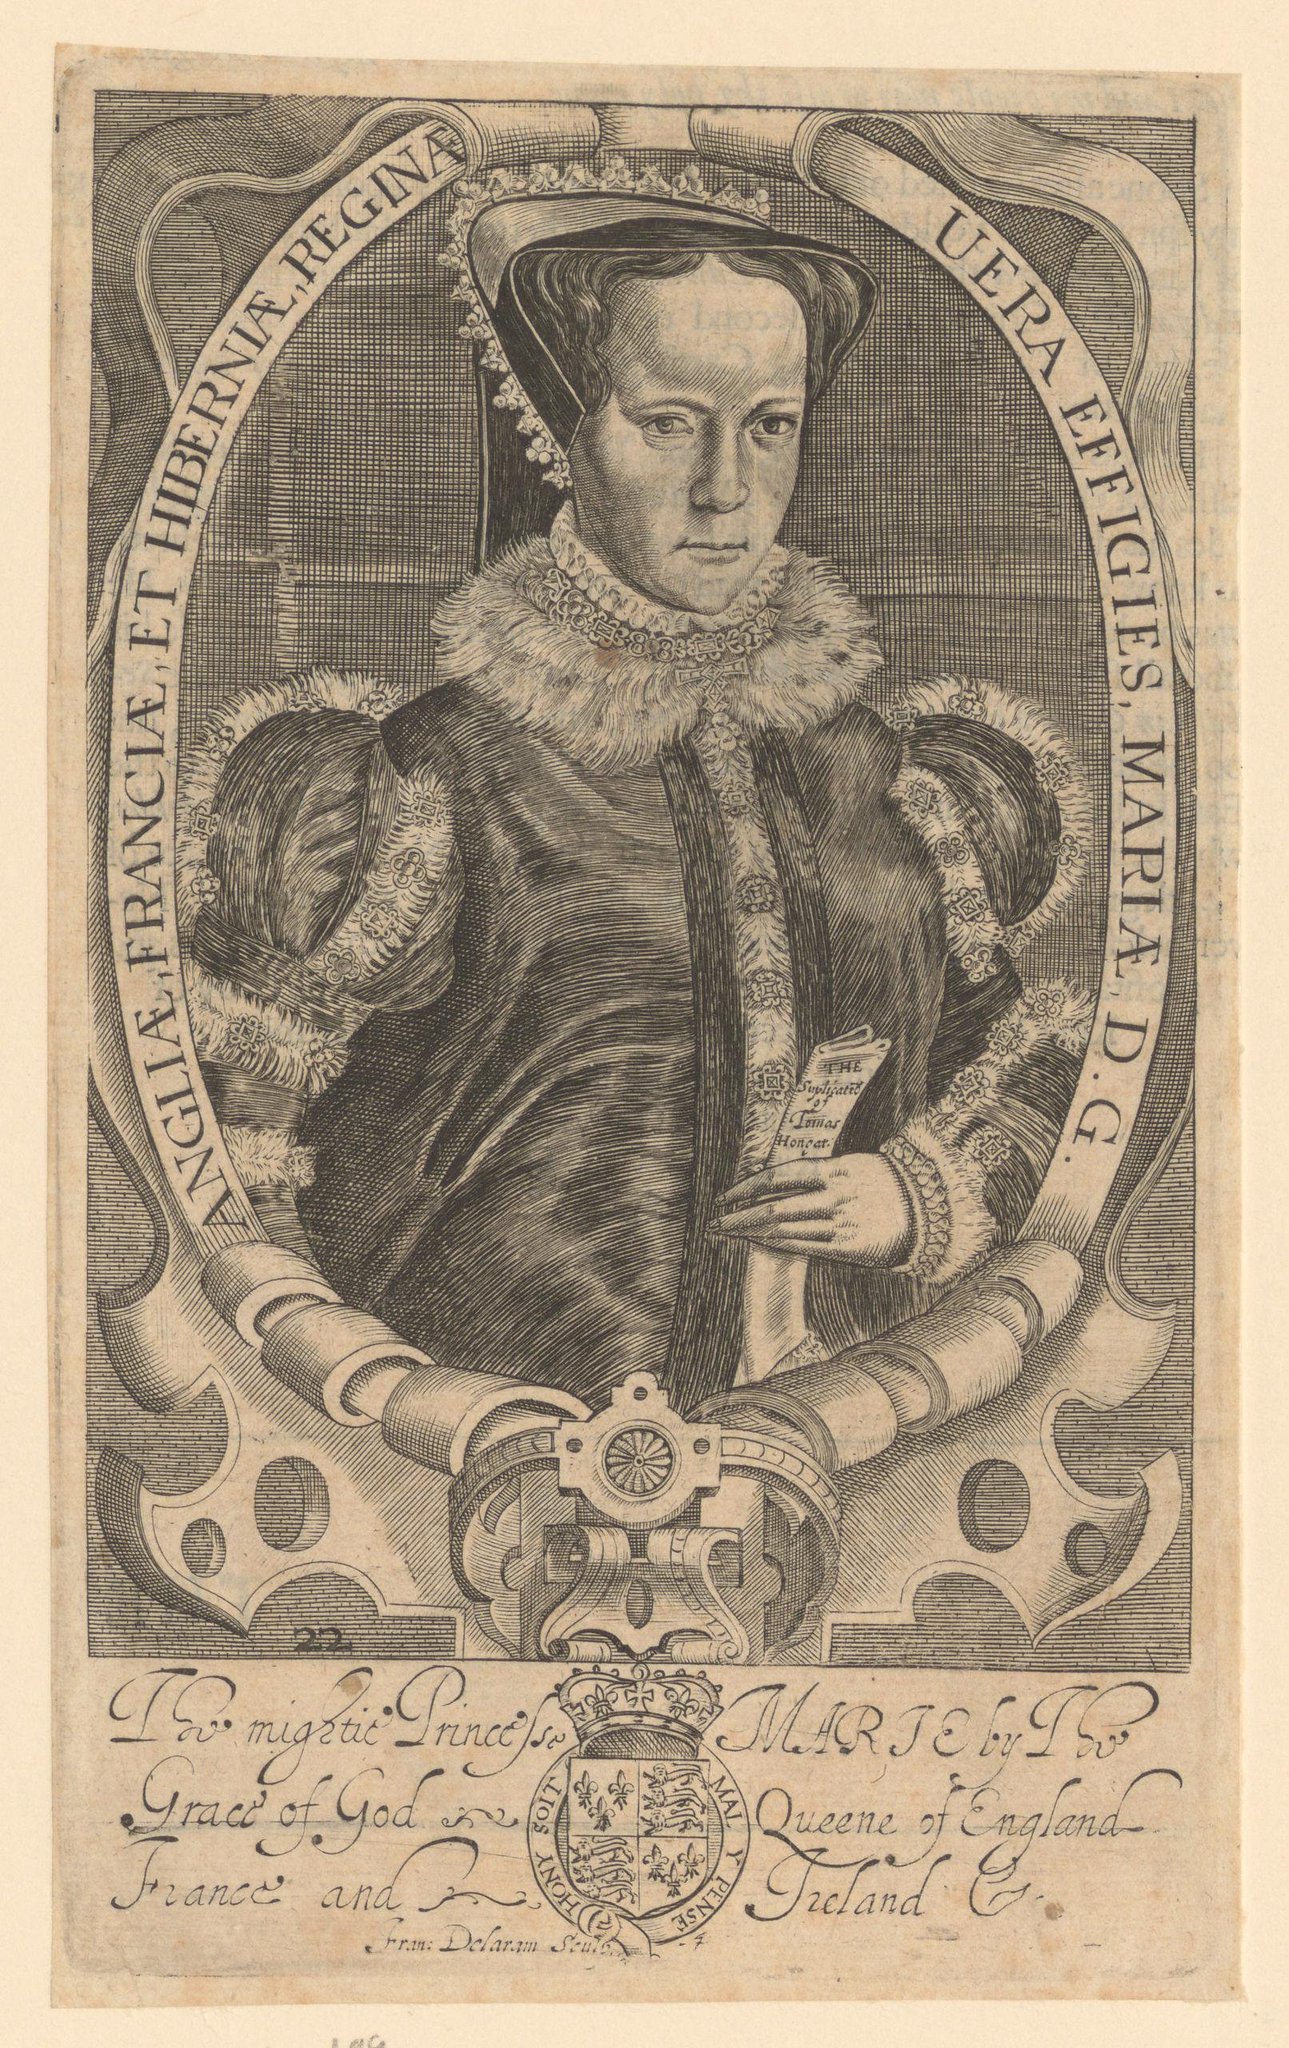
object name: book illustration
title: Portret van Maria I, koningin van Engeland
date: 1600-1618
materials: paper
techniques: engraving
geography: london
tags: london, historical persons, queen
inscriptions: collector's mark: Lugt 2760, collector's mark: Lugt 2228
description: Prent gebruik in: Baziliologia, a Booke of Kings. Londen: Compton Holland, 1618.